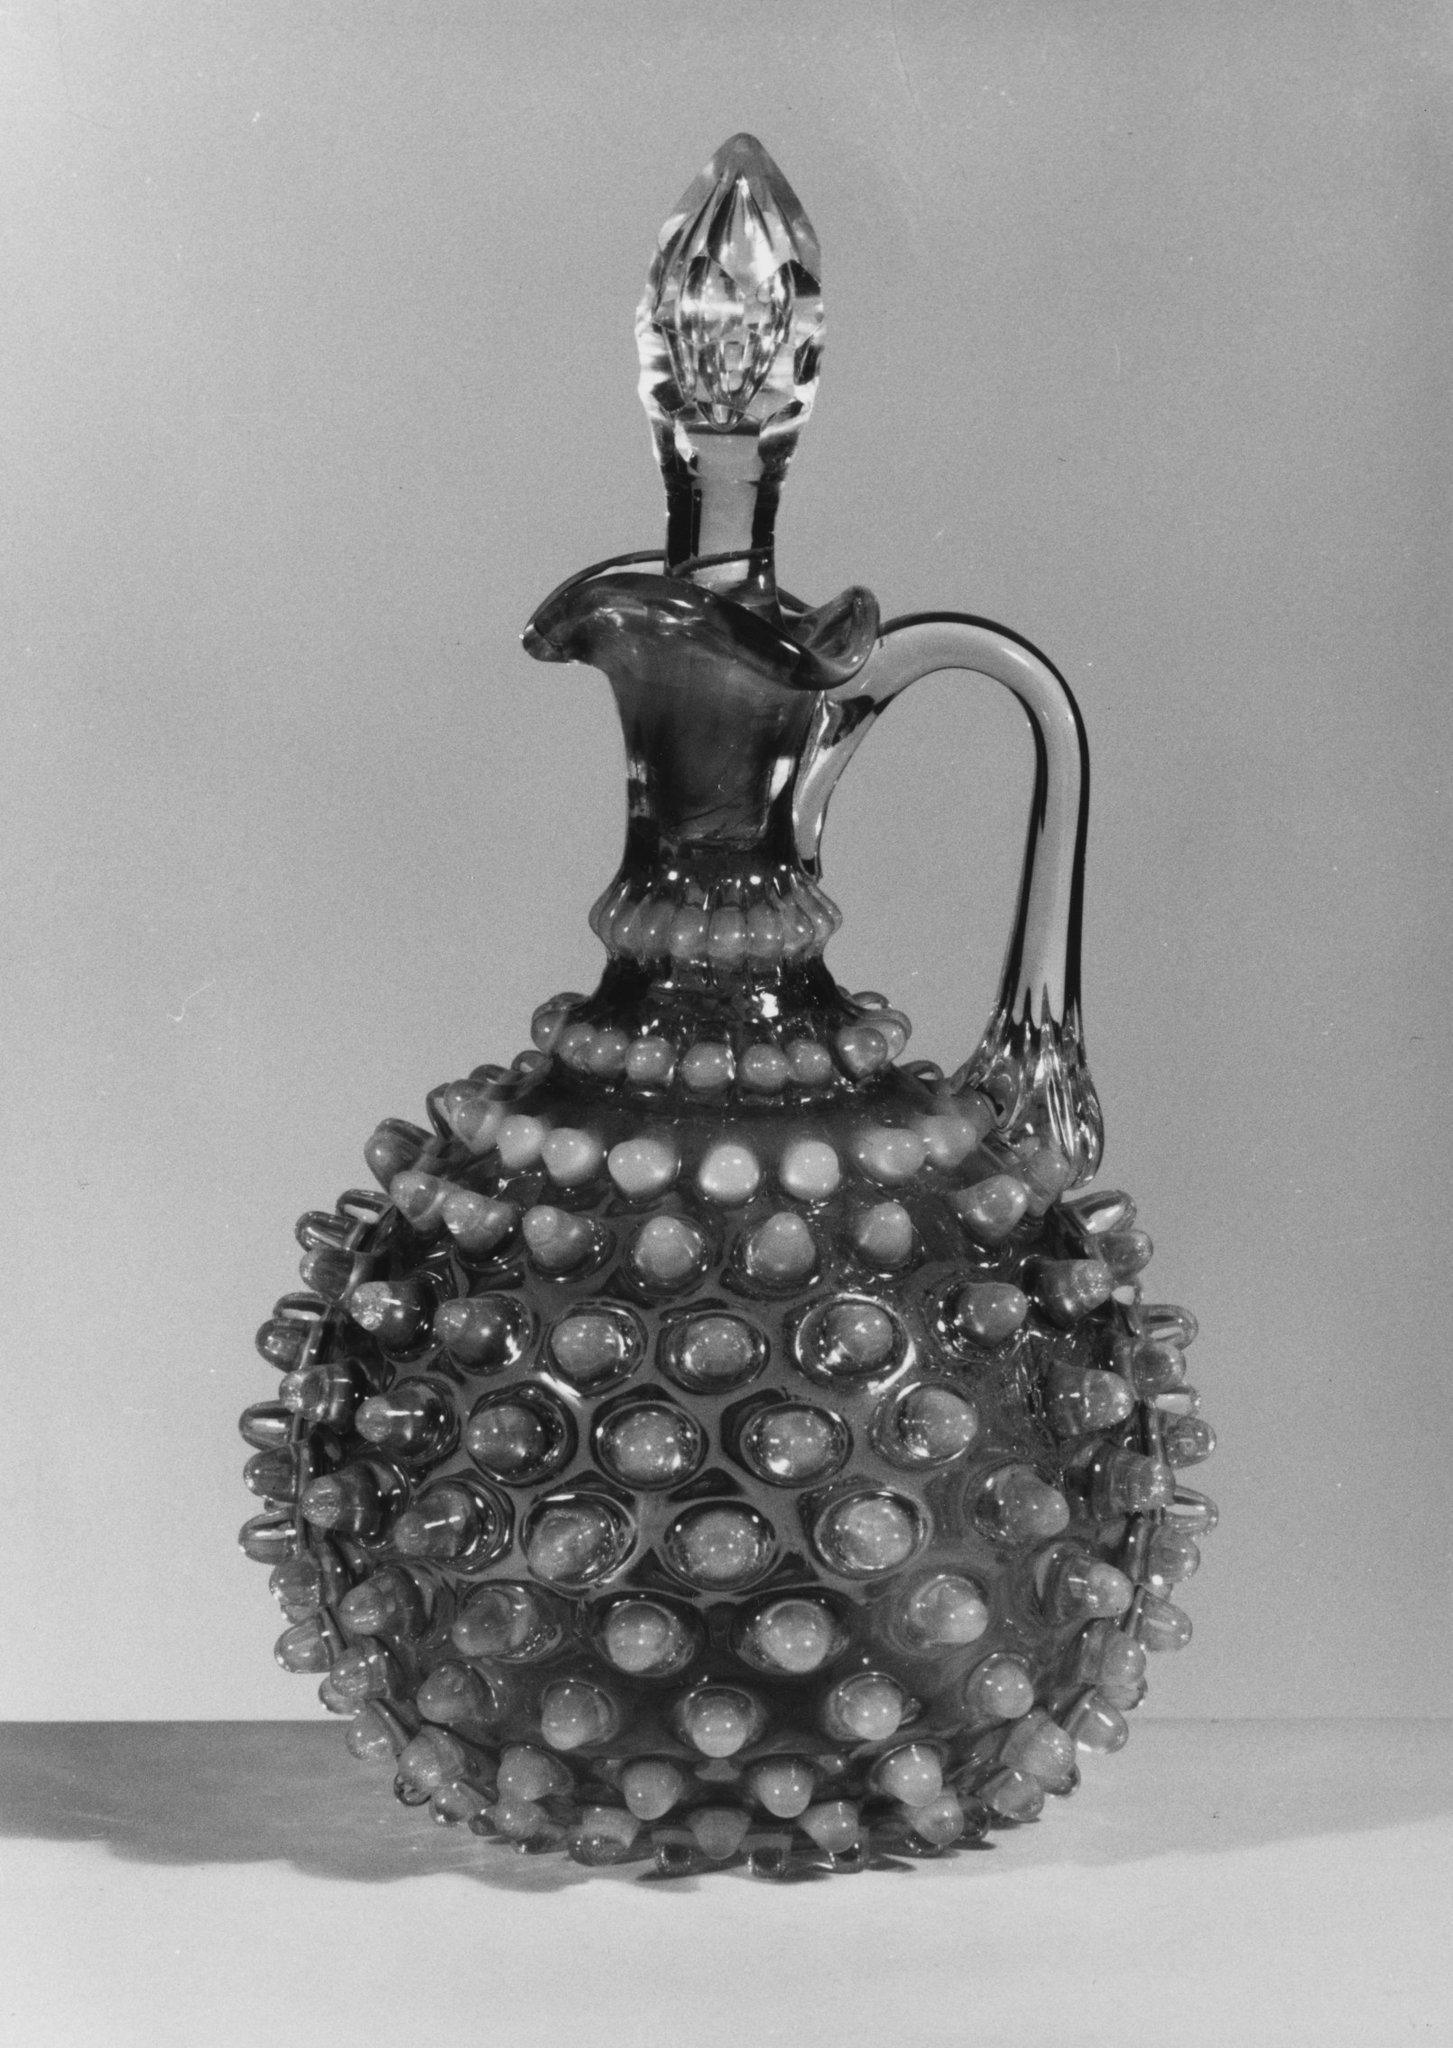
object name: cruet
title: Hobnail Cruet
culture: american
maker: hobbs, brockunier and company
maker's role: maker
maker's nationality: american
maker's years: 1863-1891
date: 1886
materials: glass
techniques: pressed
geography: united states